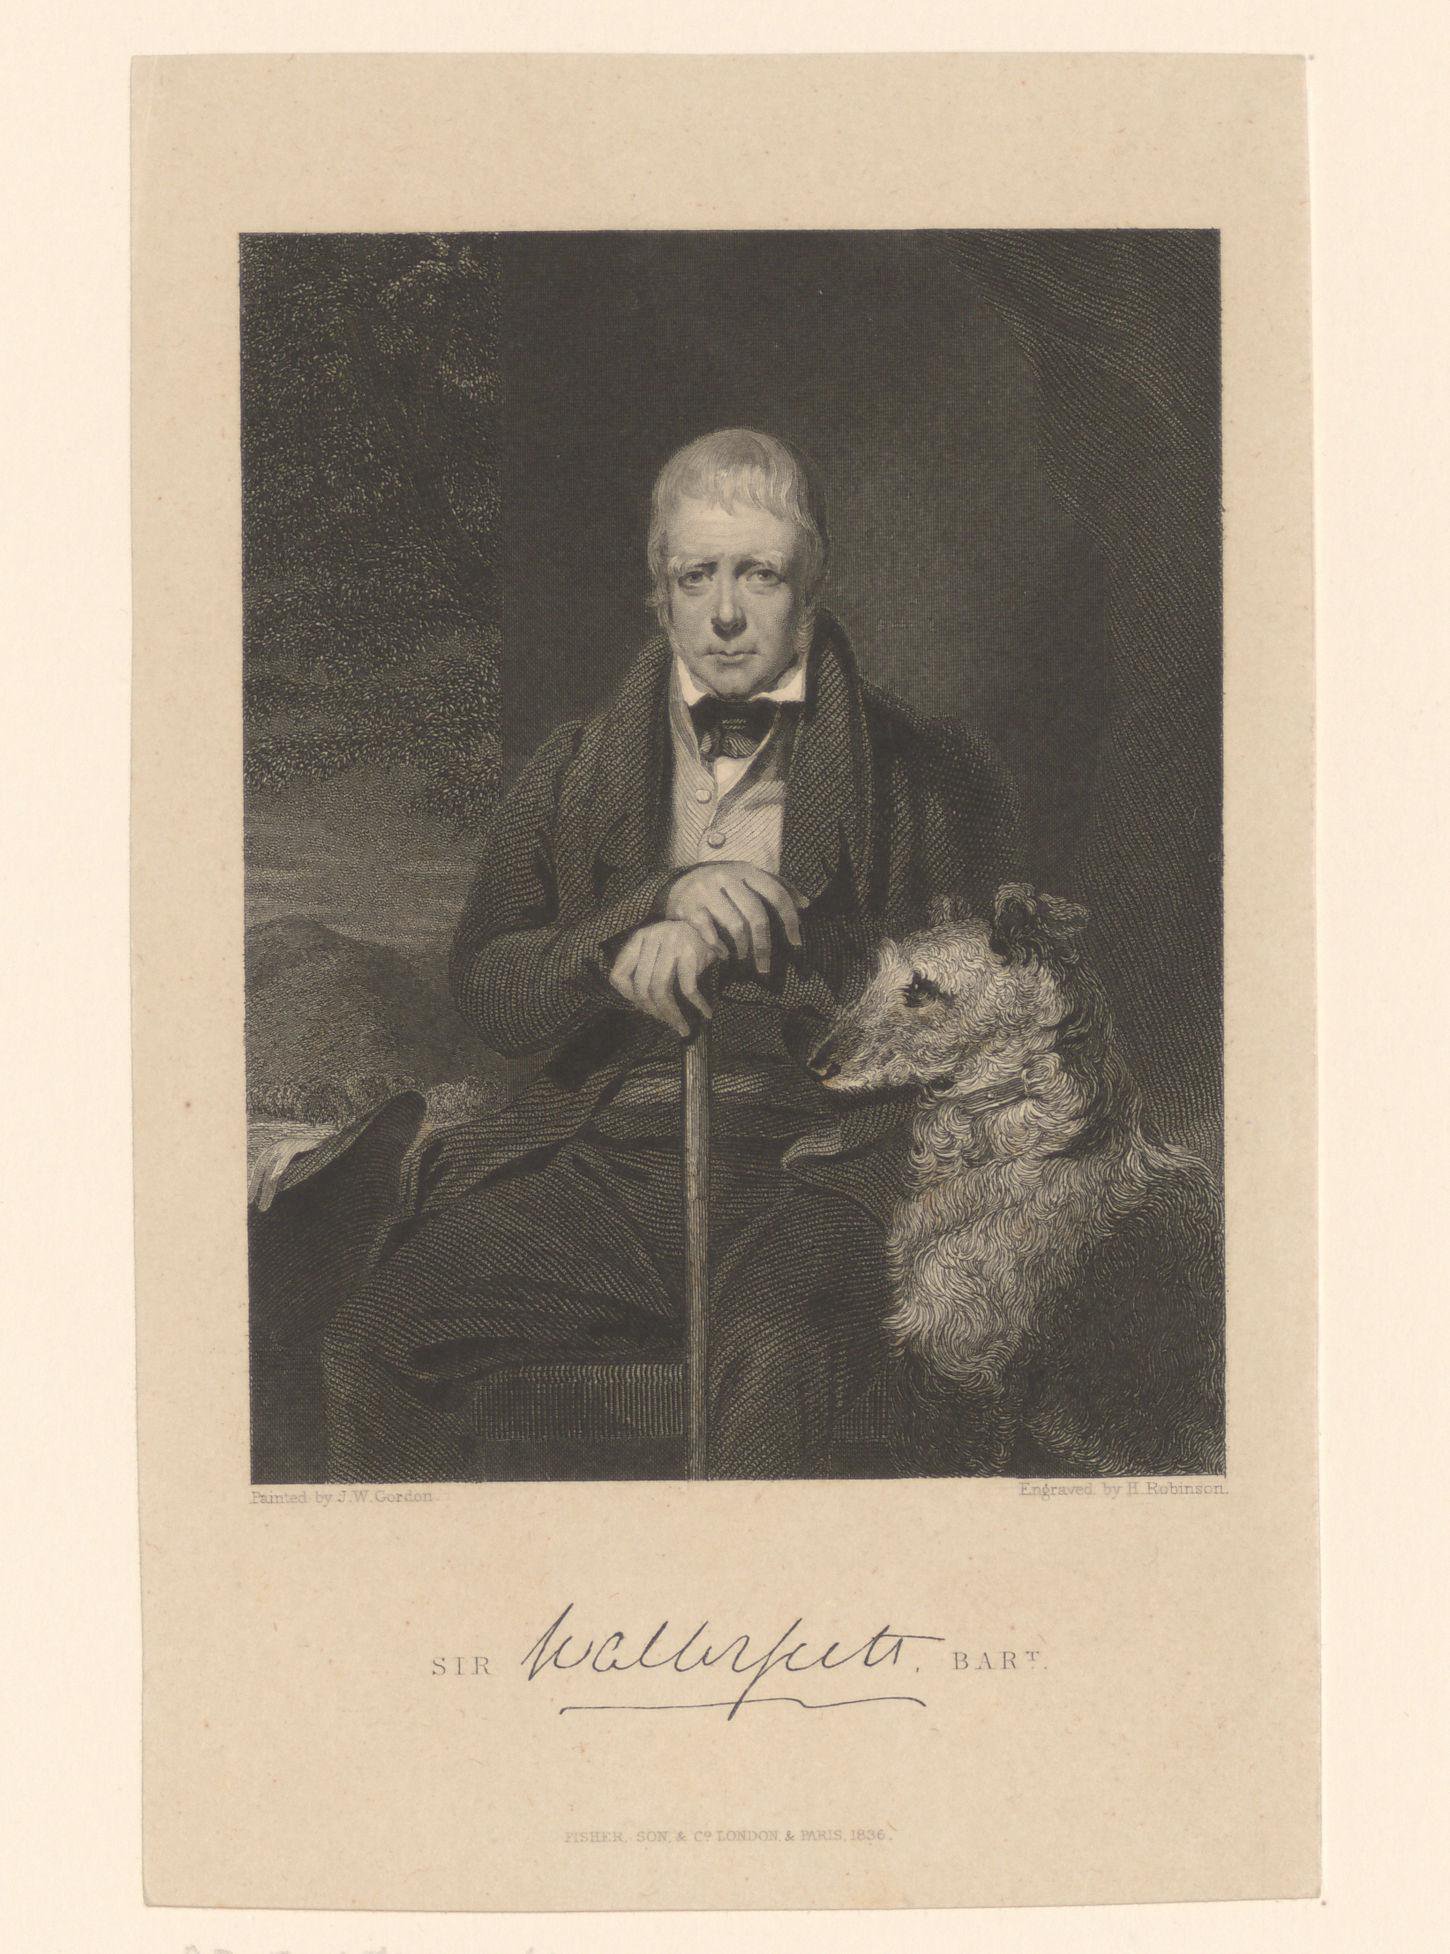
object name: print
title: Portret van Walter Scott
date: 1836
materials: paper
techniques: etching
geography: paris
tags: walter scott, historical persons, portrait of a writer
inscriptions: collector's mark: Lugt 2228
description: Een facsimile signatuur in de ondermarge.